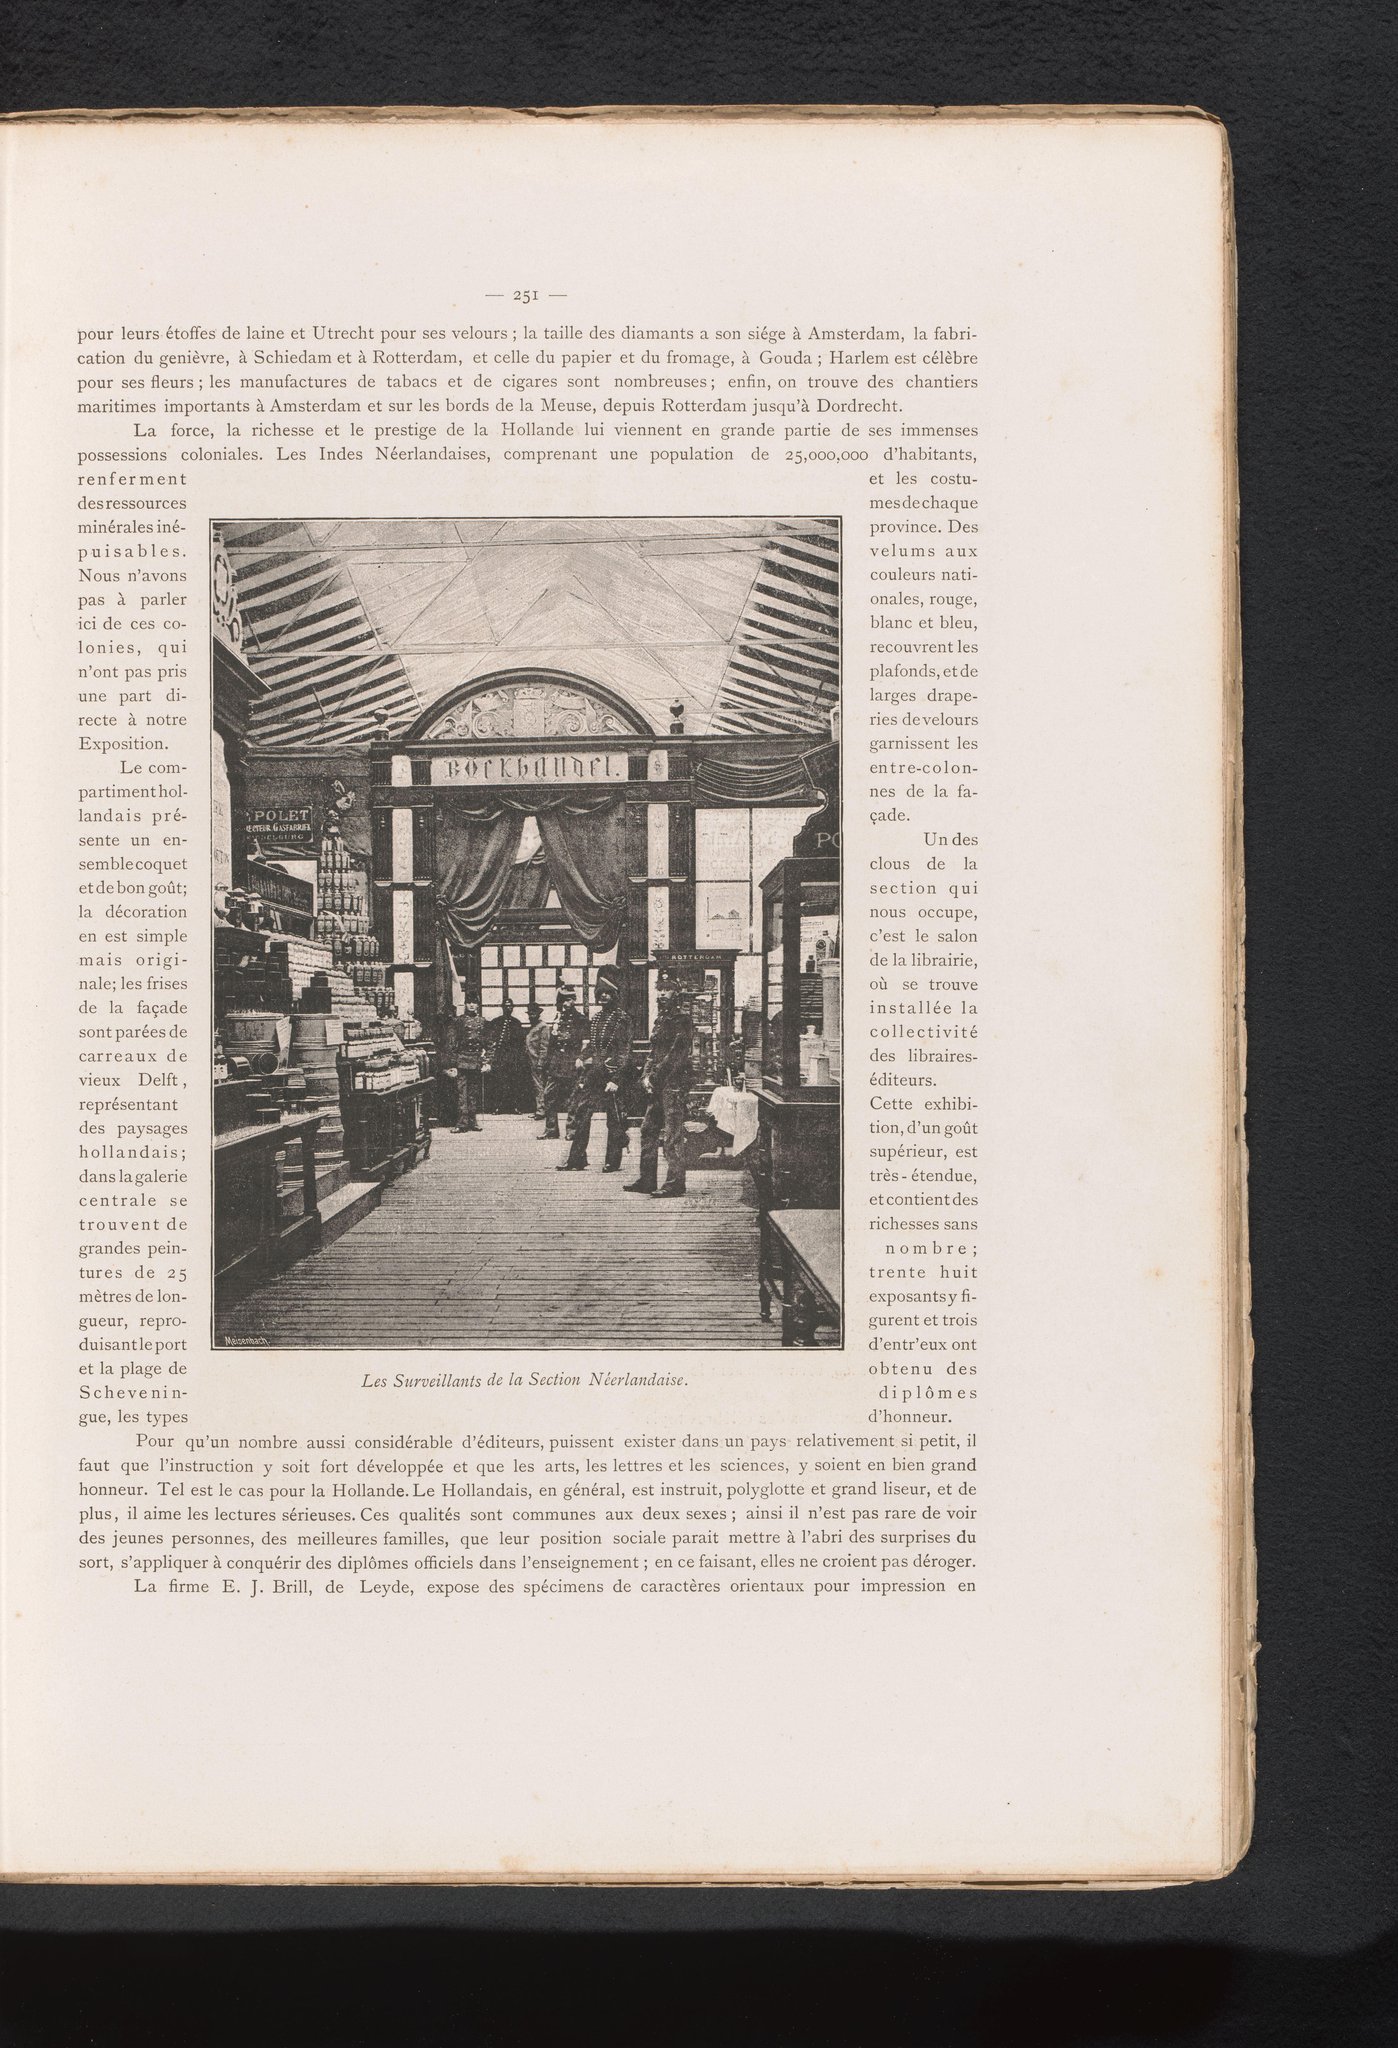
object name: page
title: Surveillanten in het Nederlandse deel van de Wereldtentoonstelling van 1885 in Antwerpen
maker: Anonymous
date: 1880-1885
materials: paper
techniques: autotype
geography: antwerp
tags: world fair, world exhibition, guard duty, keeping sentry, antwerp